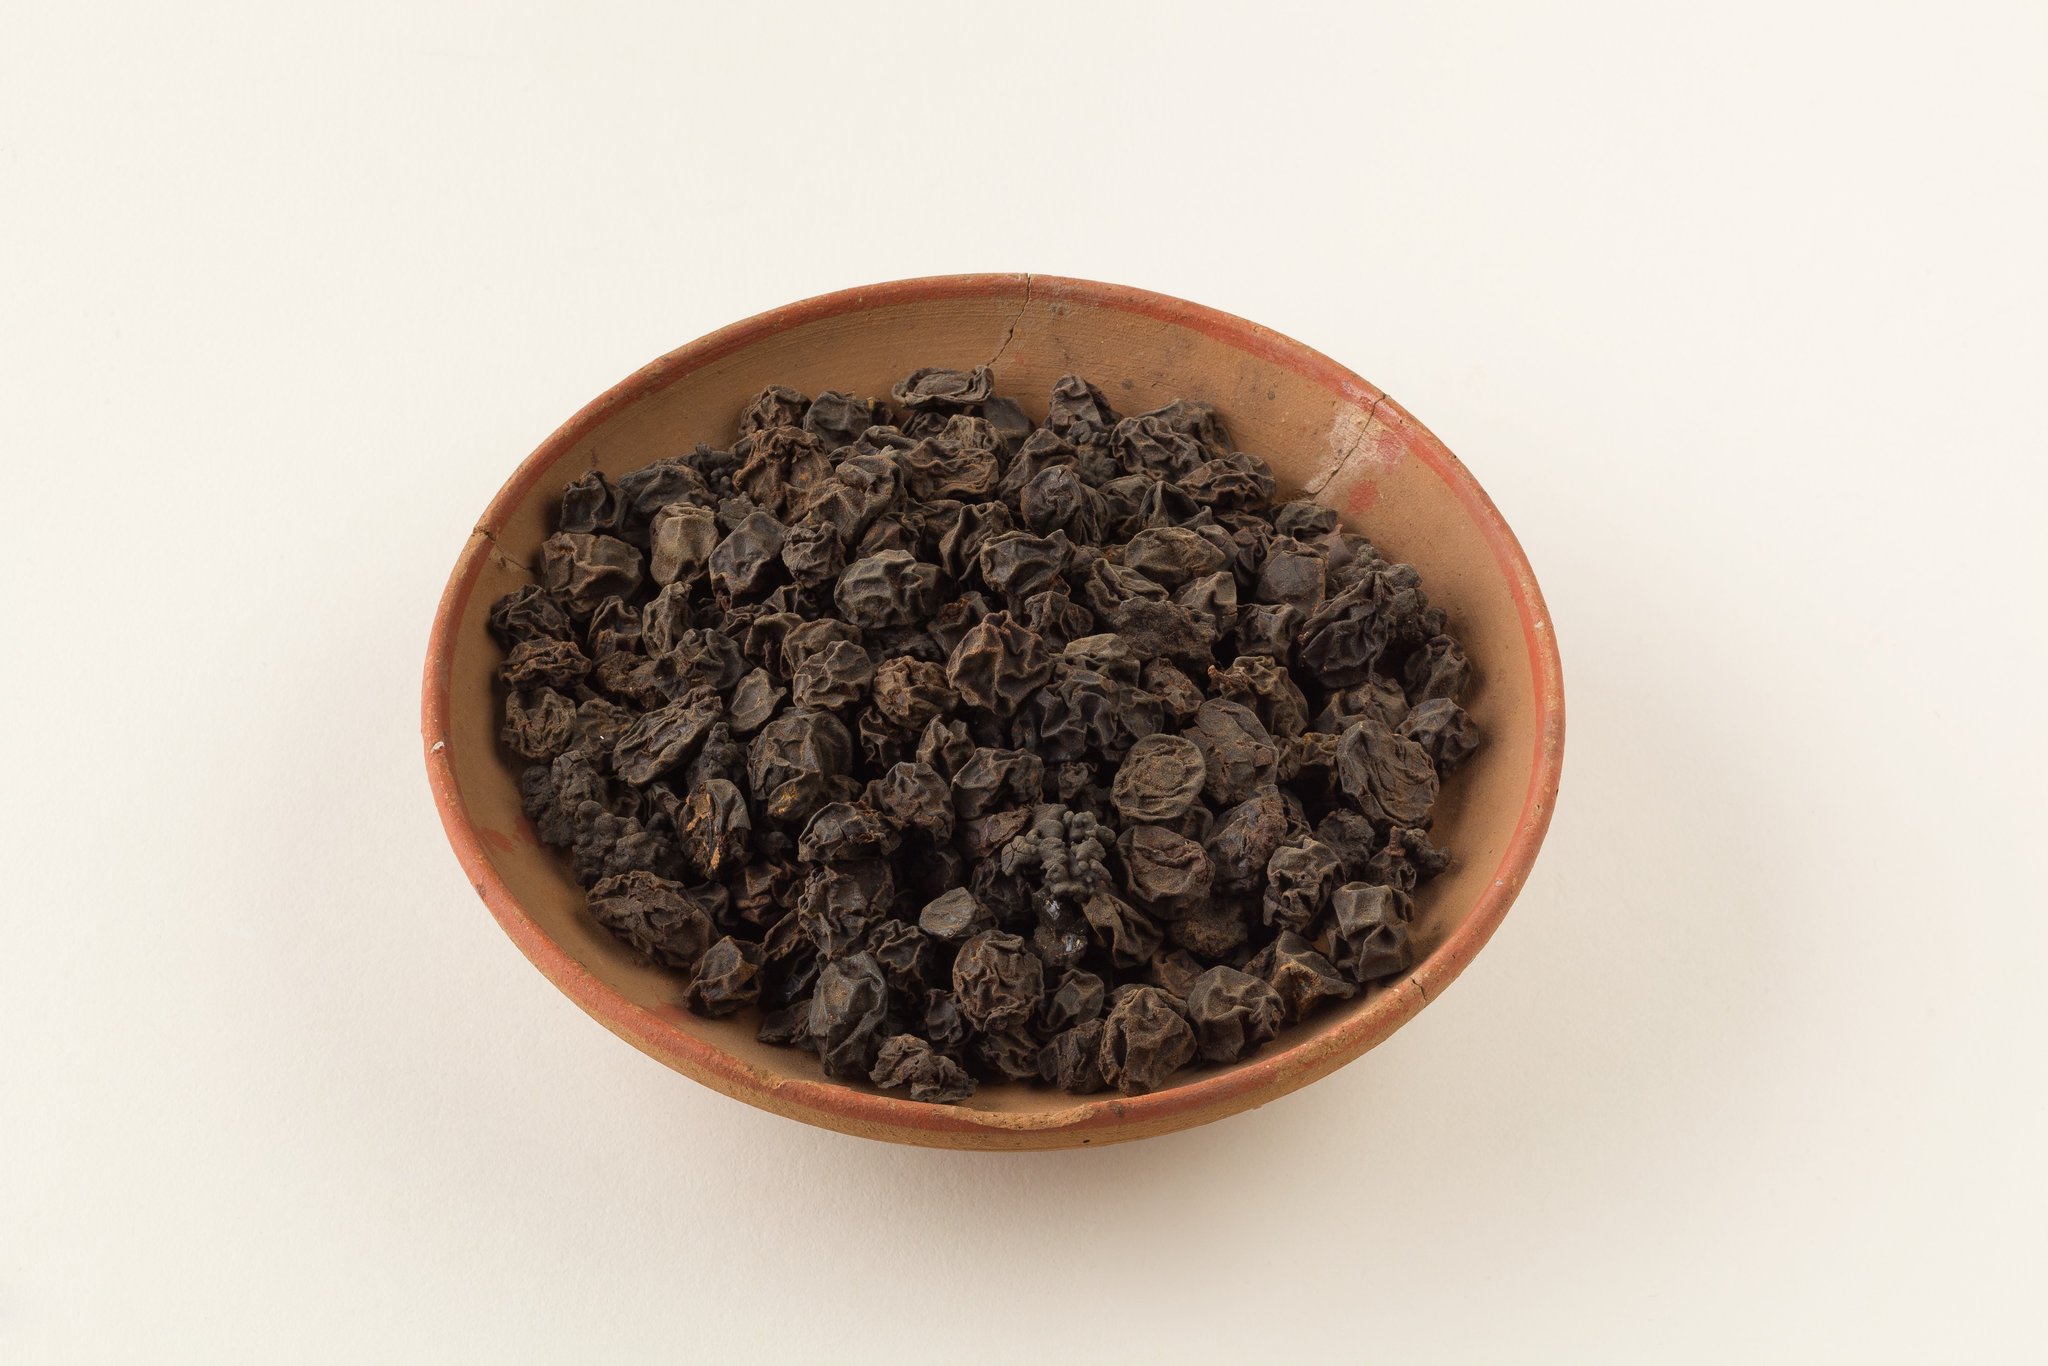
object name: dish, raisin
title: Dish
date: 1492-1473 BCE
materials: pottery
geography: egypt